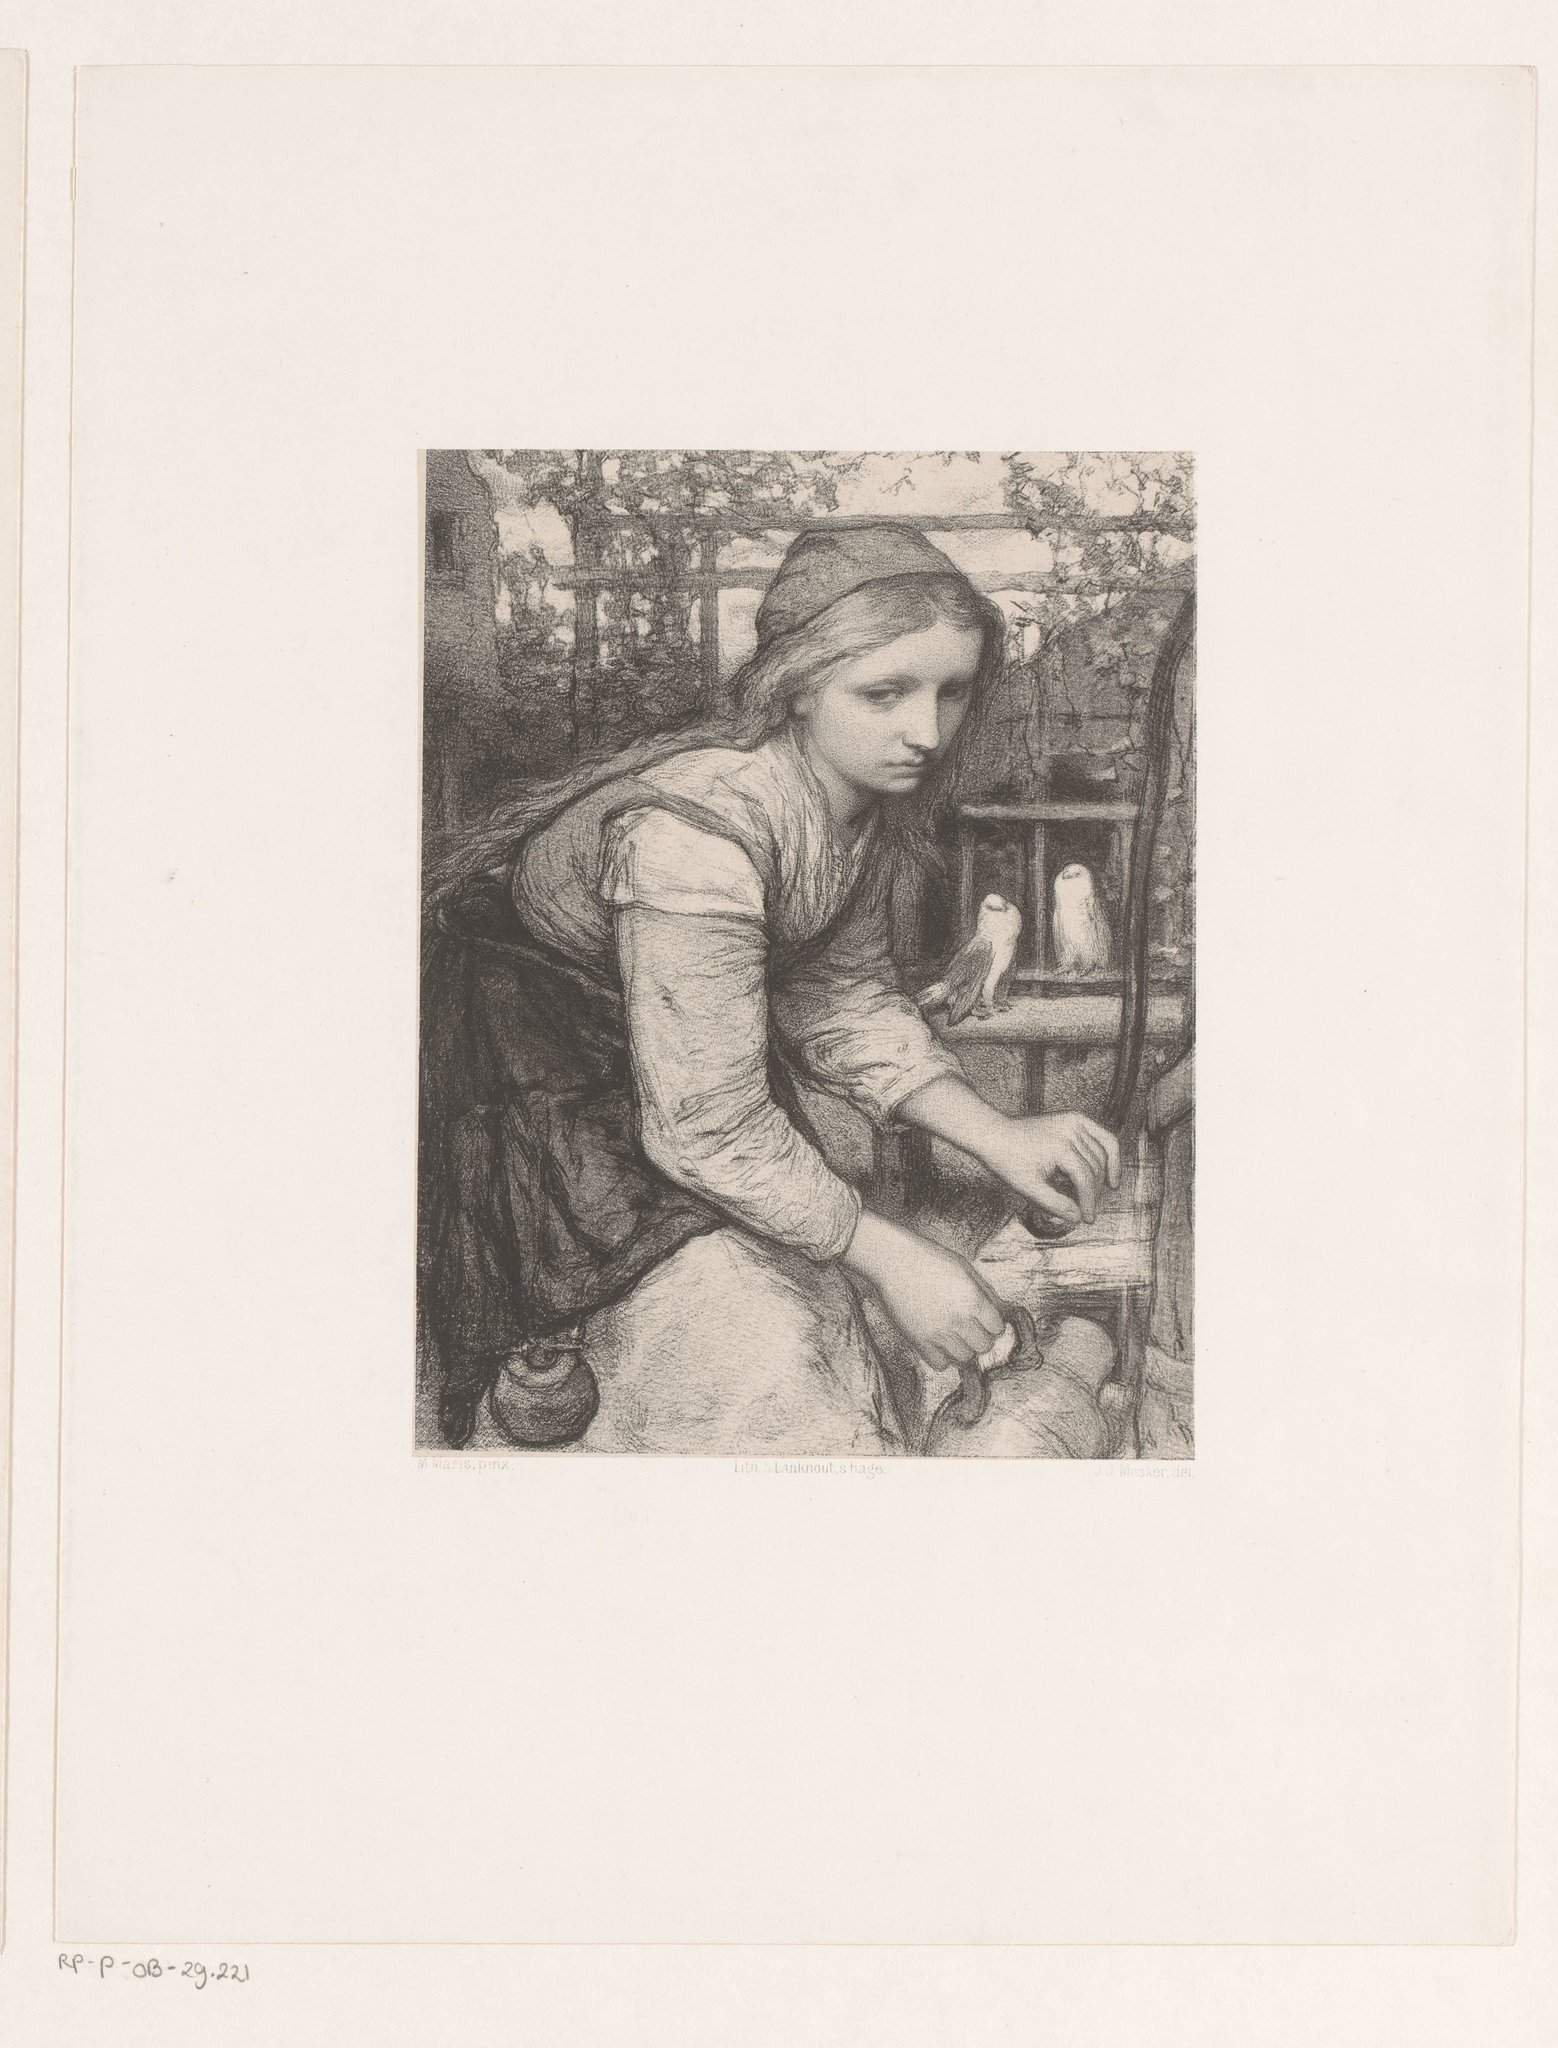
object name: print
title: Meisje aan de pomp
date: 1877-1890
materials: paper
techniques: lithograph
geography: the hague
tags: adolescent, young woman, maiden, other birds: dove, pump